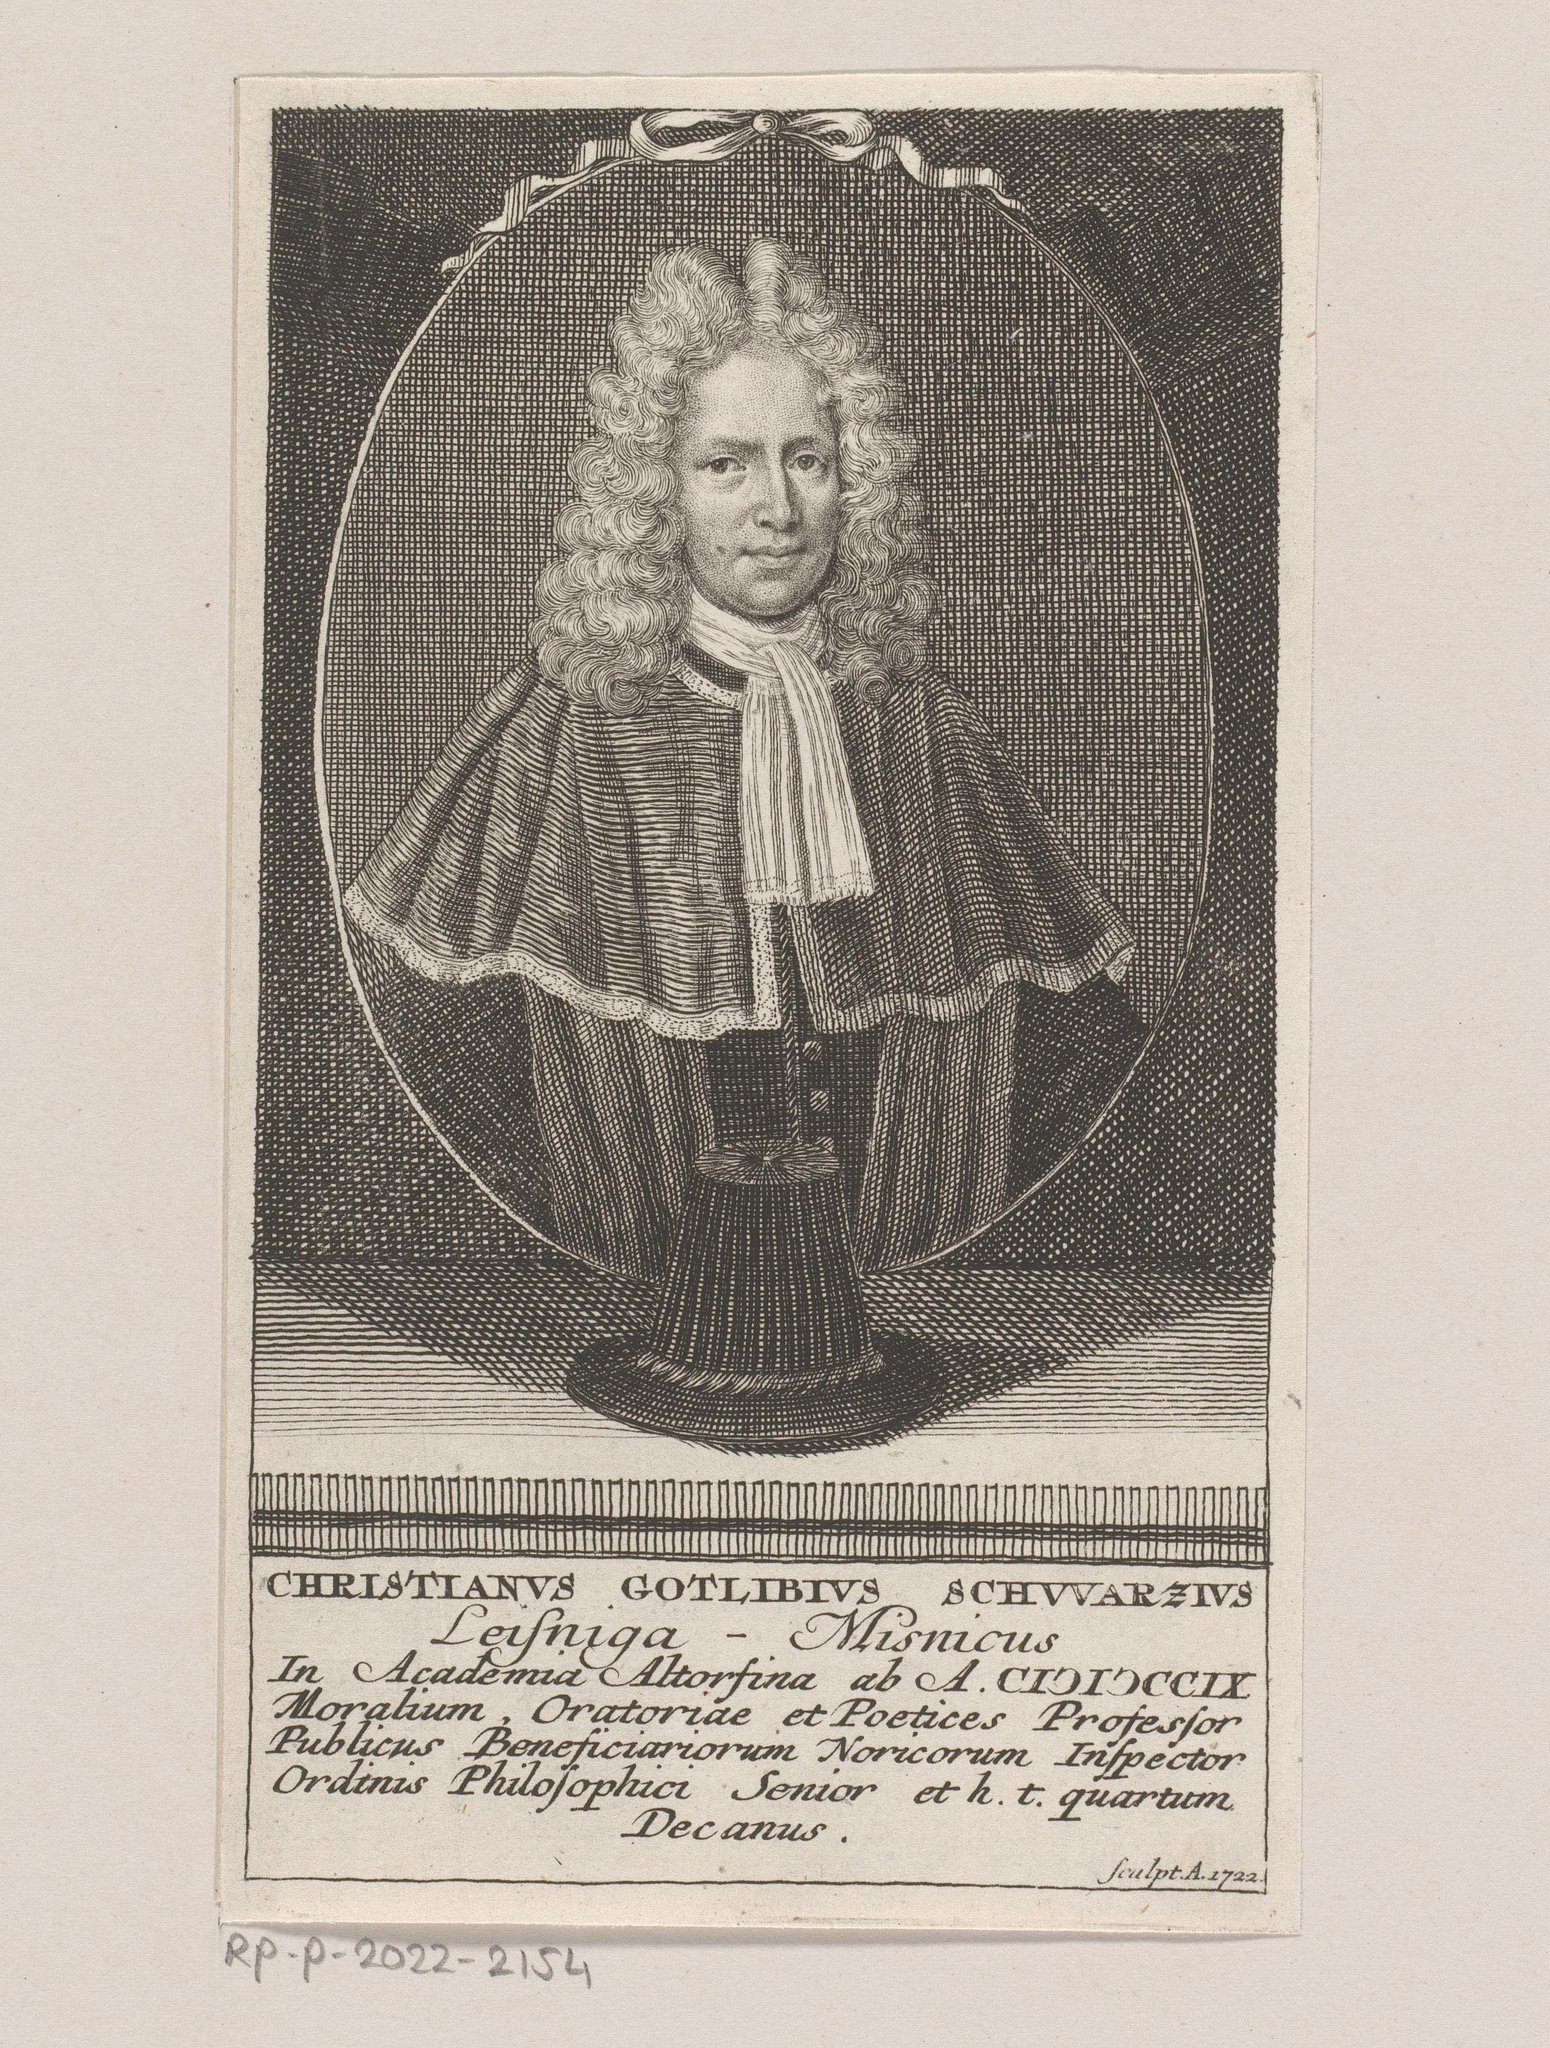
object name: print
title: Portret van Christian Gottlieb Schwarz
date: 1722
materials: paper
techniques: engraving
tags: historical persons, portrait of a writer, historical disciplines; philology (+ portrait of scholar, scientist), professor, armorial bearing, heraldry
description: Prent waarschijnlijk uit: Apin, Siegmund Jacob. Vitae Professorum philosophiae qui a condita Academia Altorfina ad hunc usque diem claruerunt. Neurenberg en Altdorf: erven Johann Daniel Tauber, 1728.